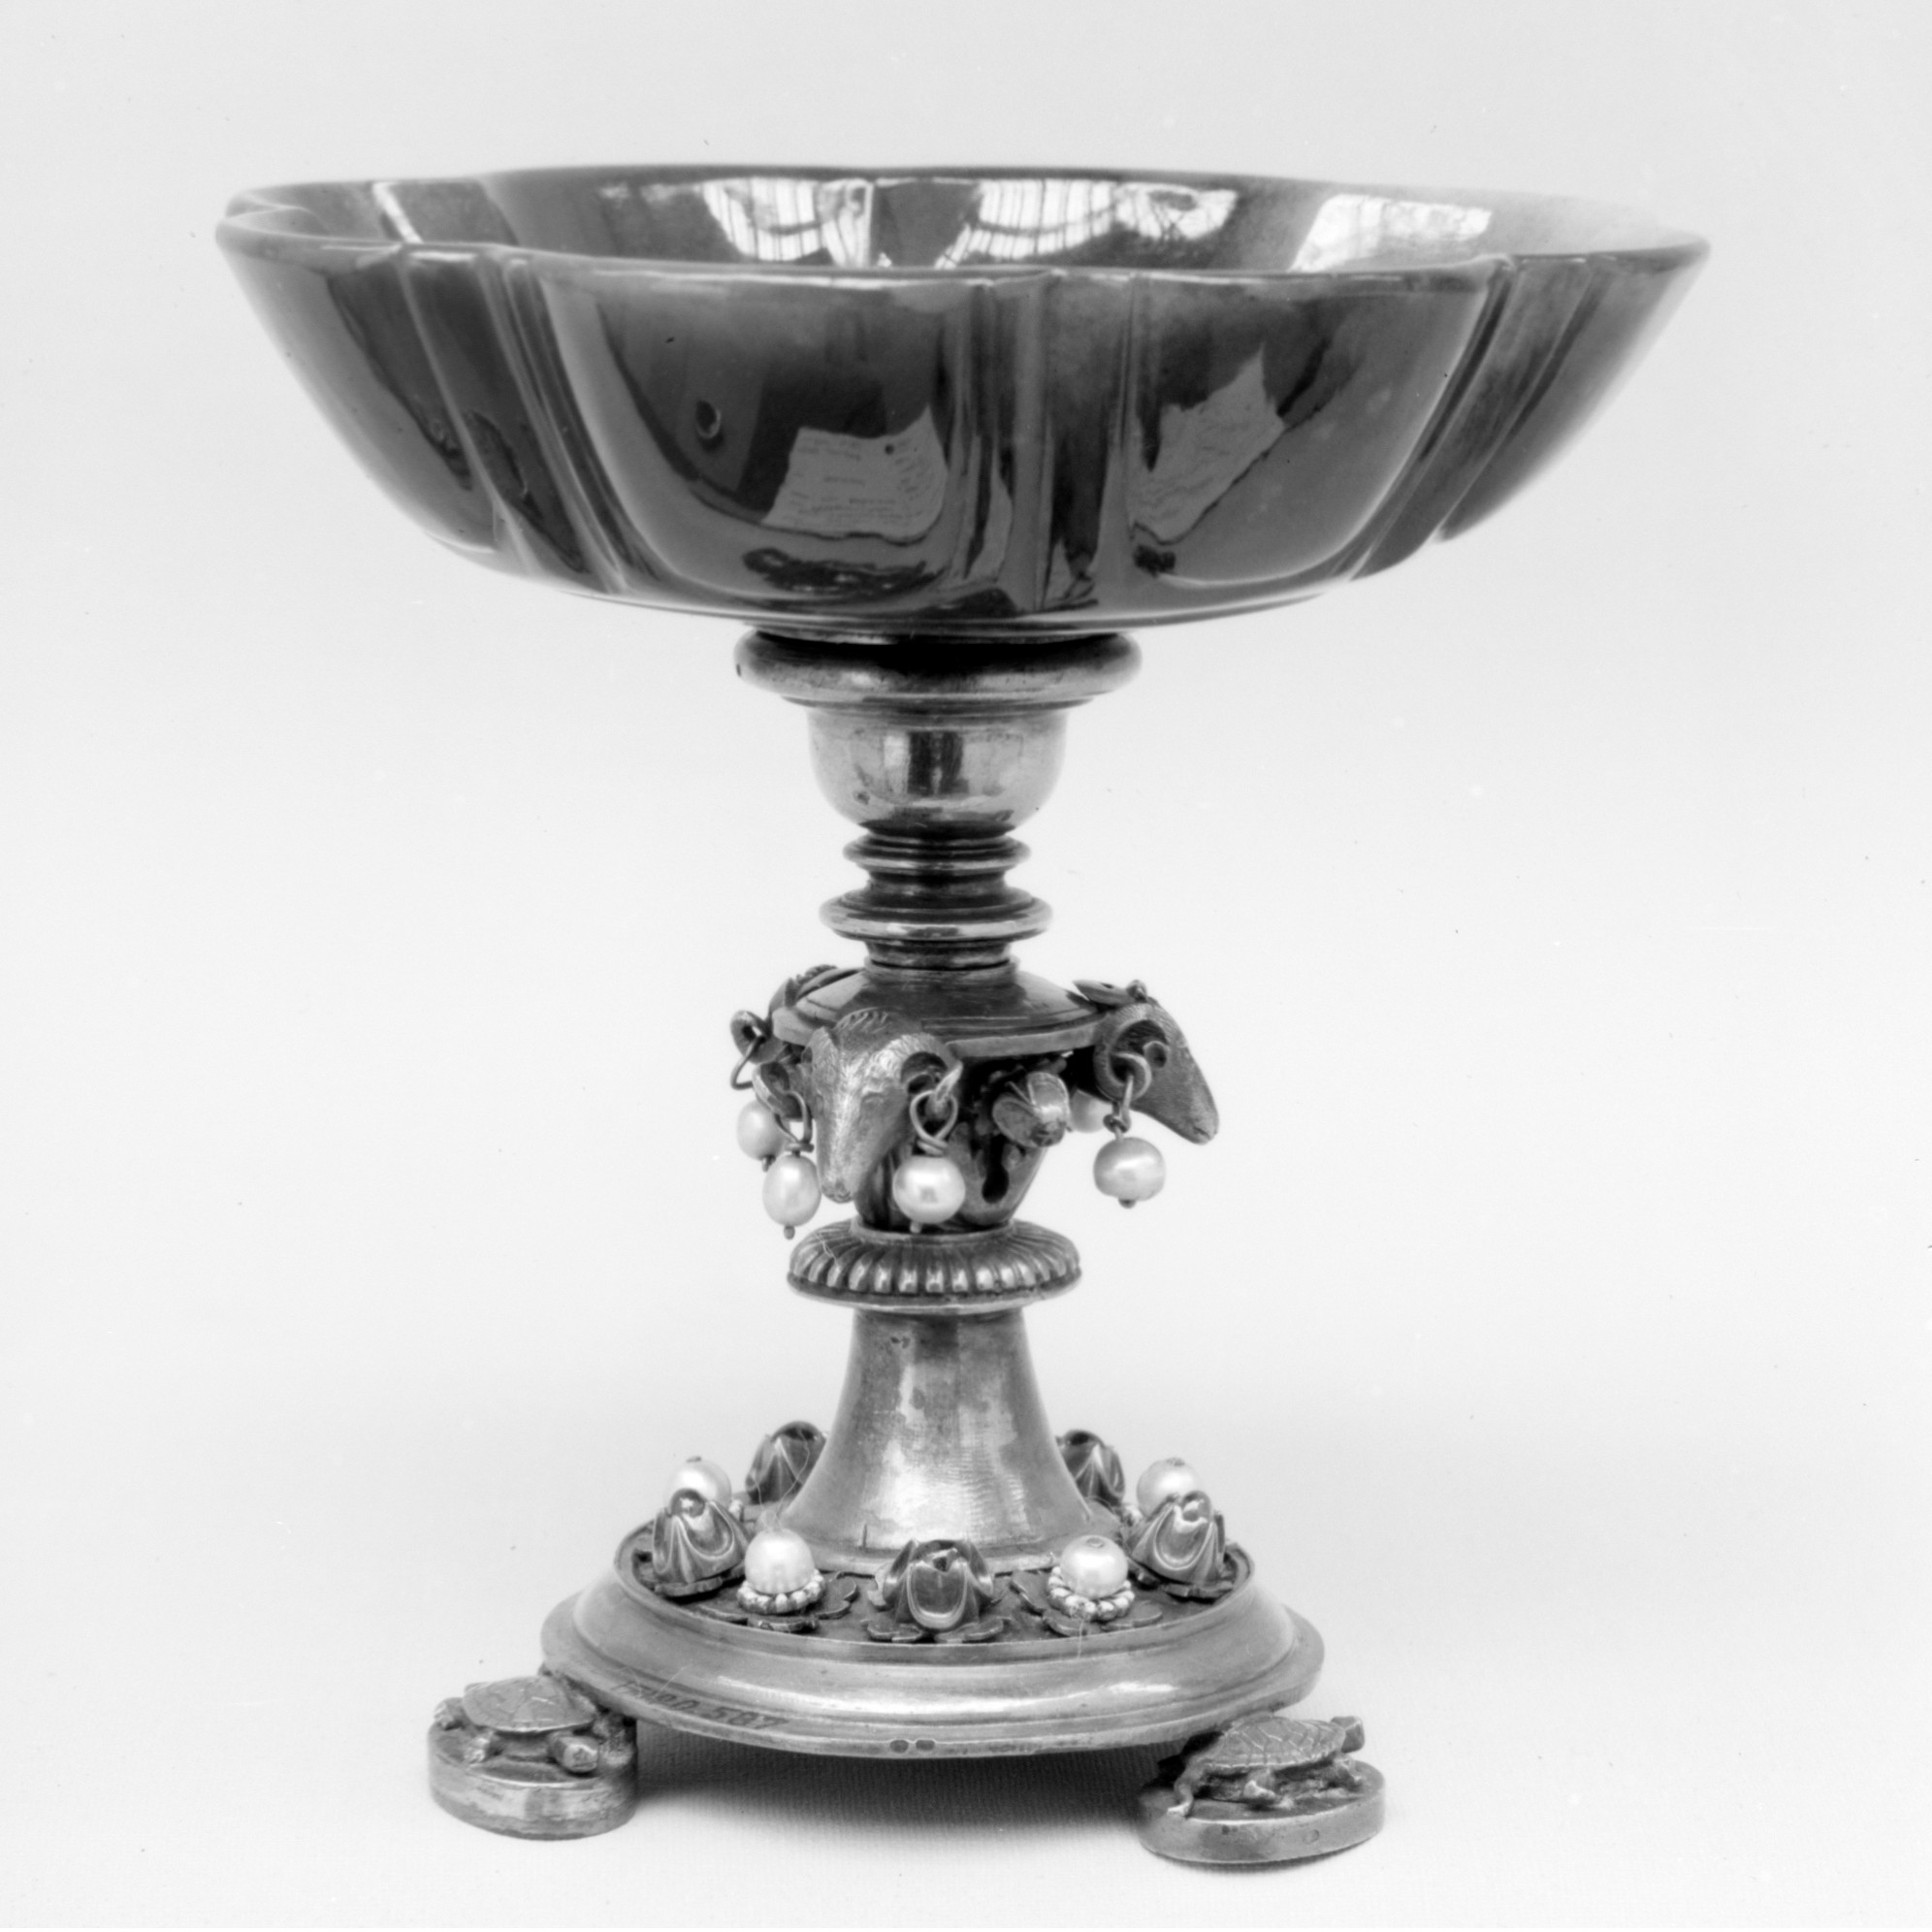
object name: cup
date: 1834-1866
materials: stone, silver gilt